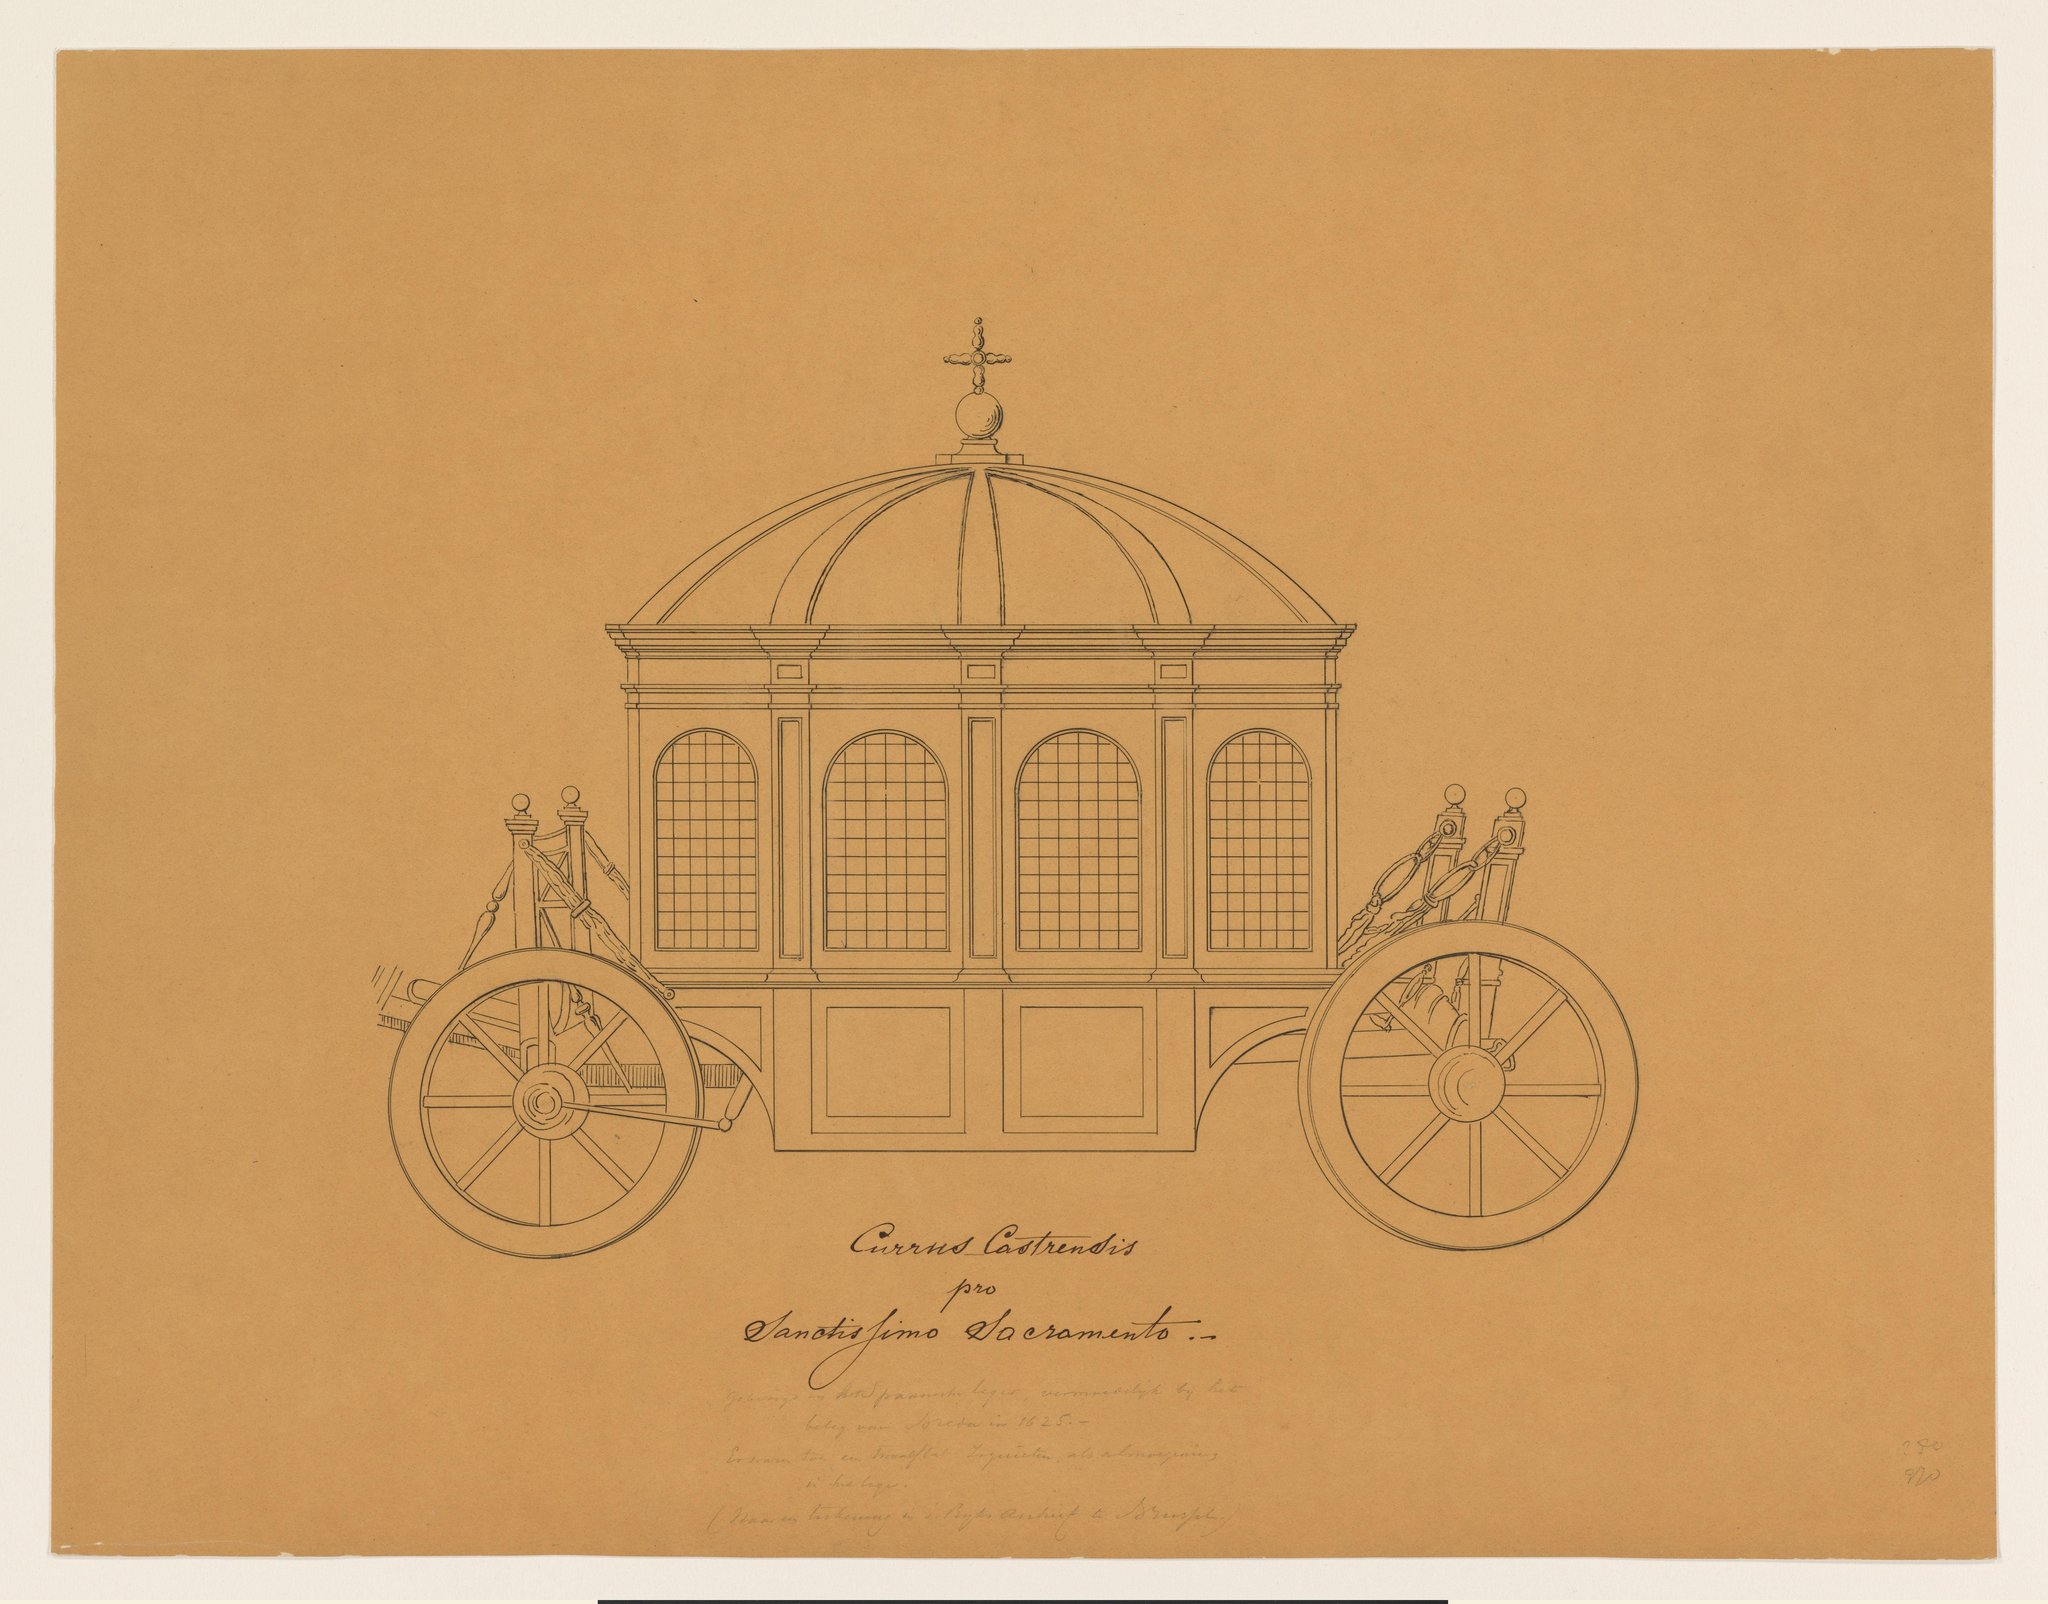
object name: drawing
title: Vierwielig rijtuig waarin het H. Sacrament vervoerd werd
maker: Anonymous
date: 1800-1888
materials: ink, paper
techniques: pen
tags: four-wheeled, animal-drawn vehicle, e.g.: cab, carriage, coach